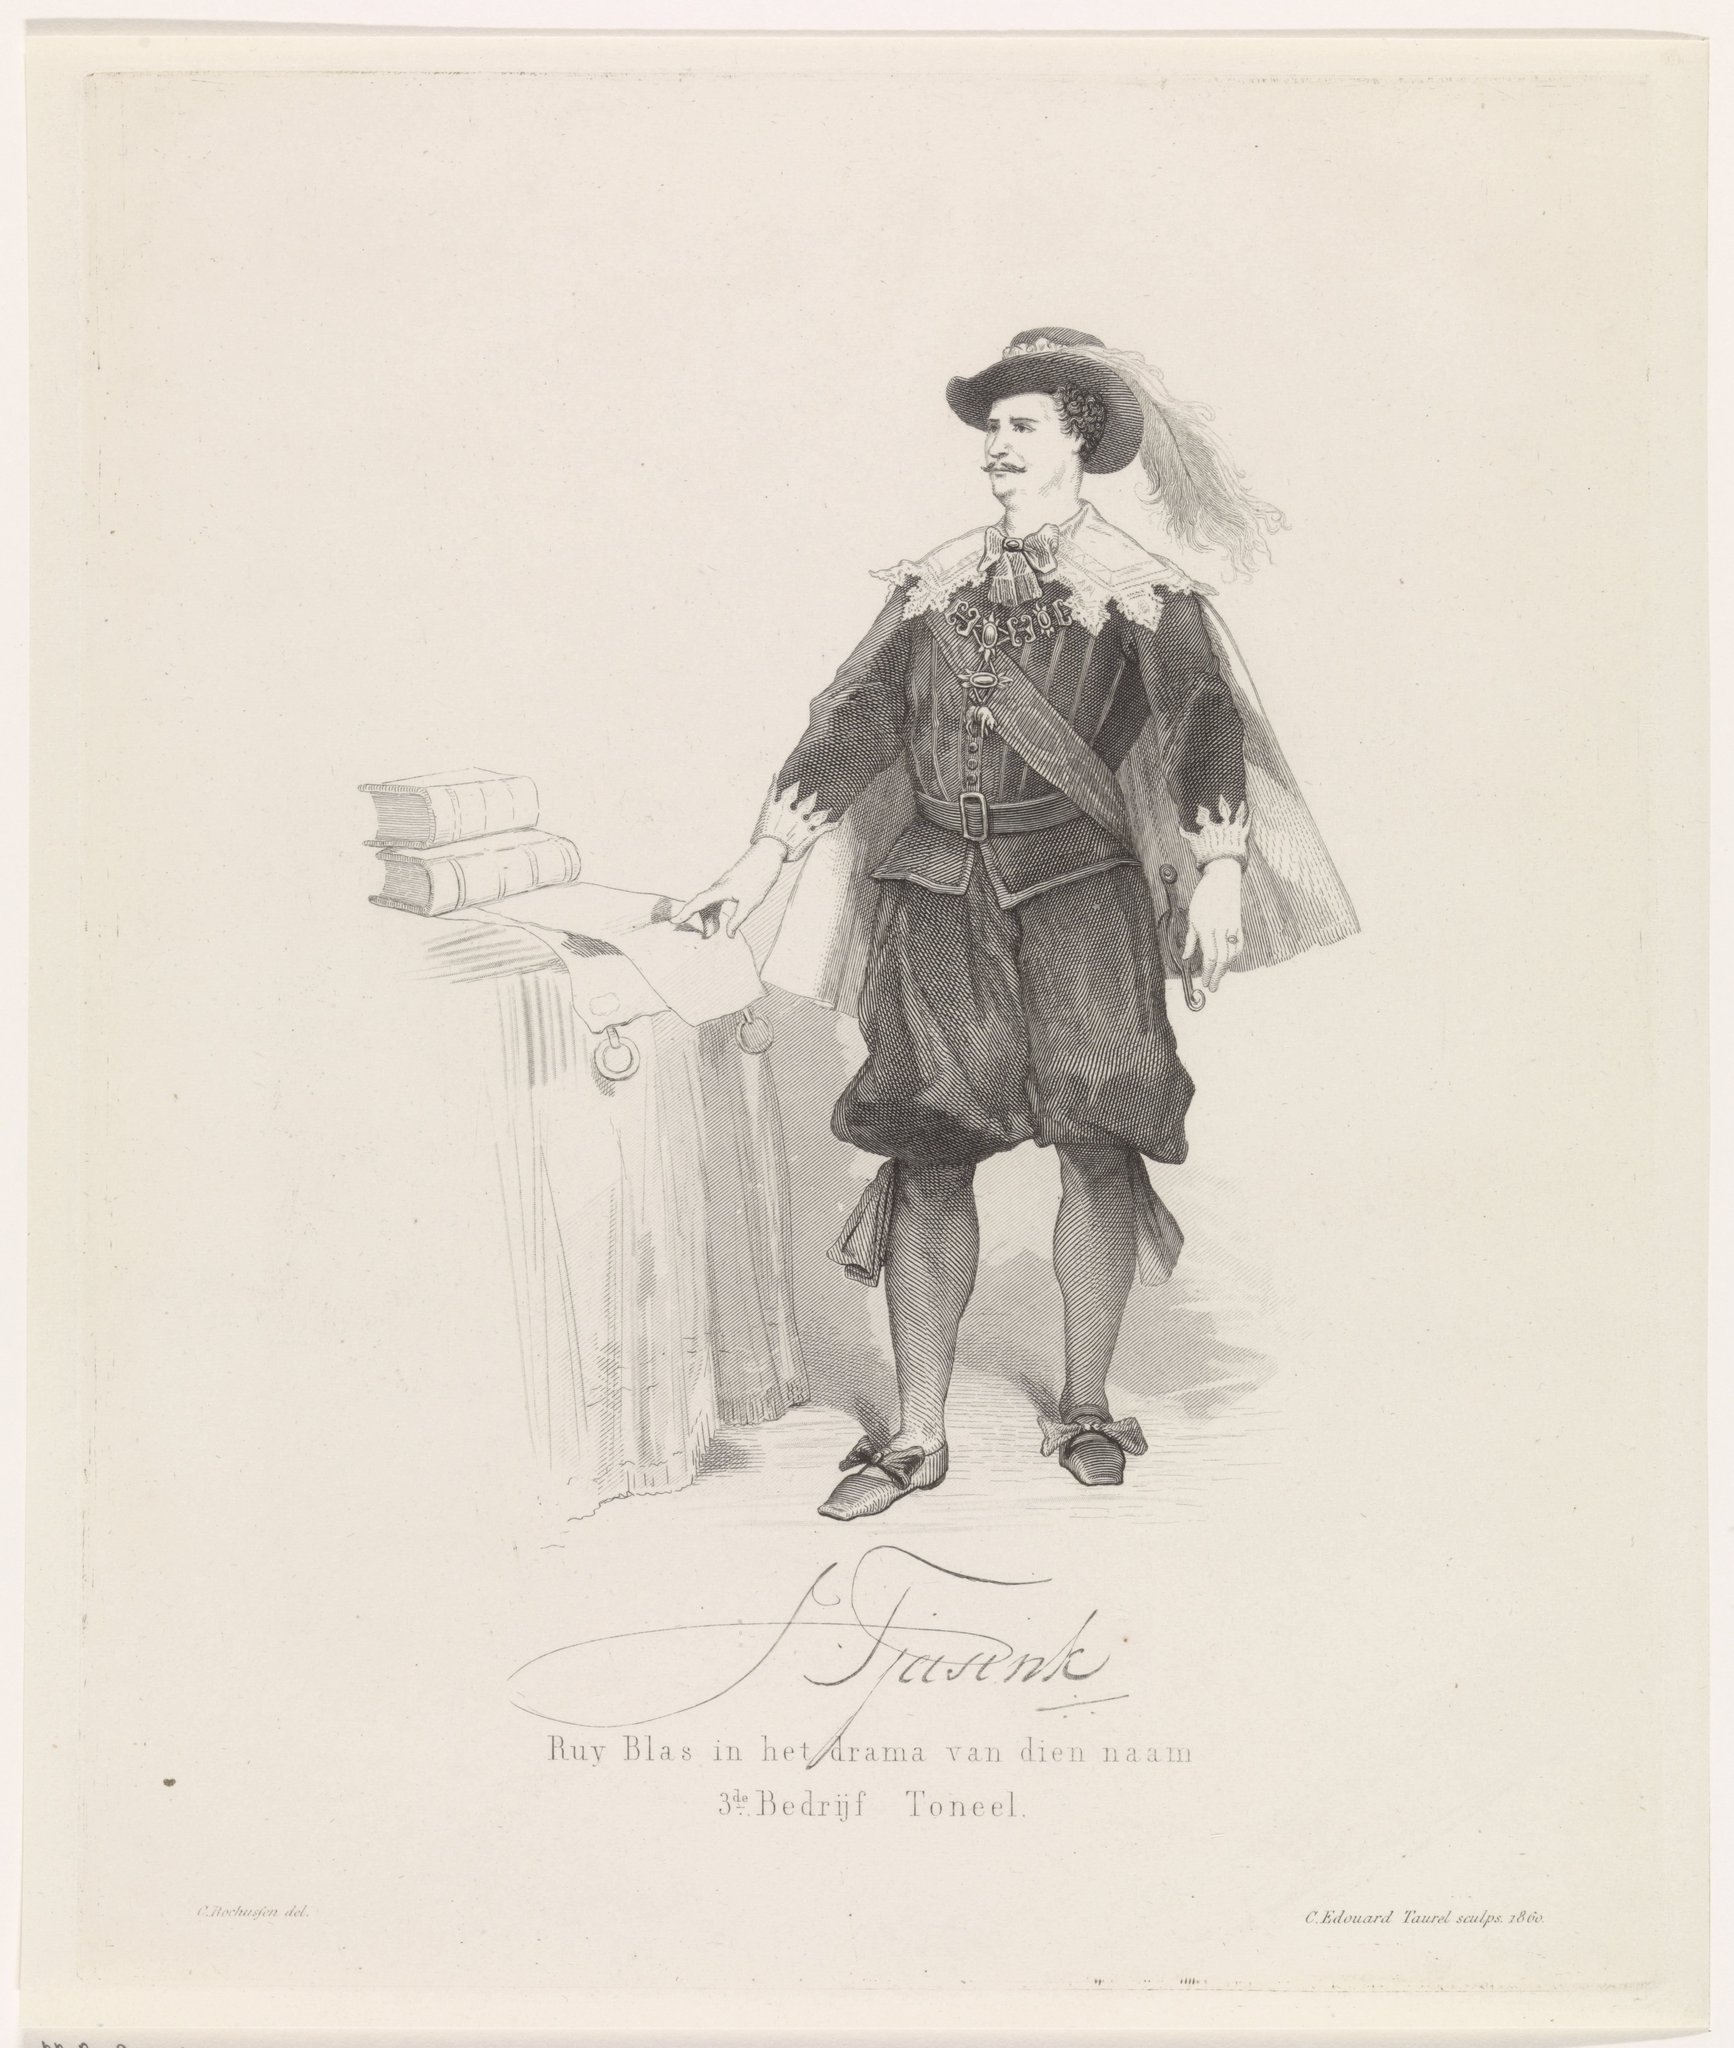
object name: print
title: Portret van de Haagse toneelspeler Johan Tjasink als Ruys-Blas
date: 1860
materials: paper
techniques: engraving, etching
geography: amsterdam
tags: paris, victor hugo, portrait of actor, actress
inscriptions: collector's mark: Lugt 2228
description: De Haagse toneelspeler Johan Tjasink als het personage Ruys-Blas, uit het gelijknamige drama van Victor Hugo. Johan Tjasink, in zeventiende eeuws kostuum, als de als edelman vermomde dienaar Ruy Blas, naast een tafel waarop documenten en boeken.